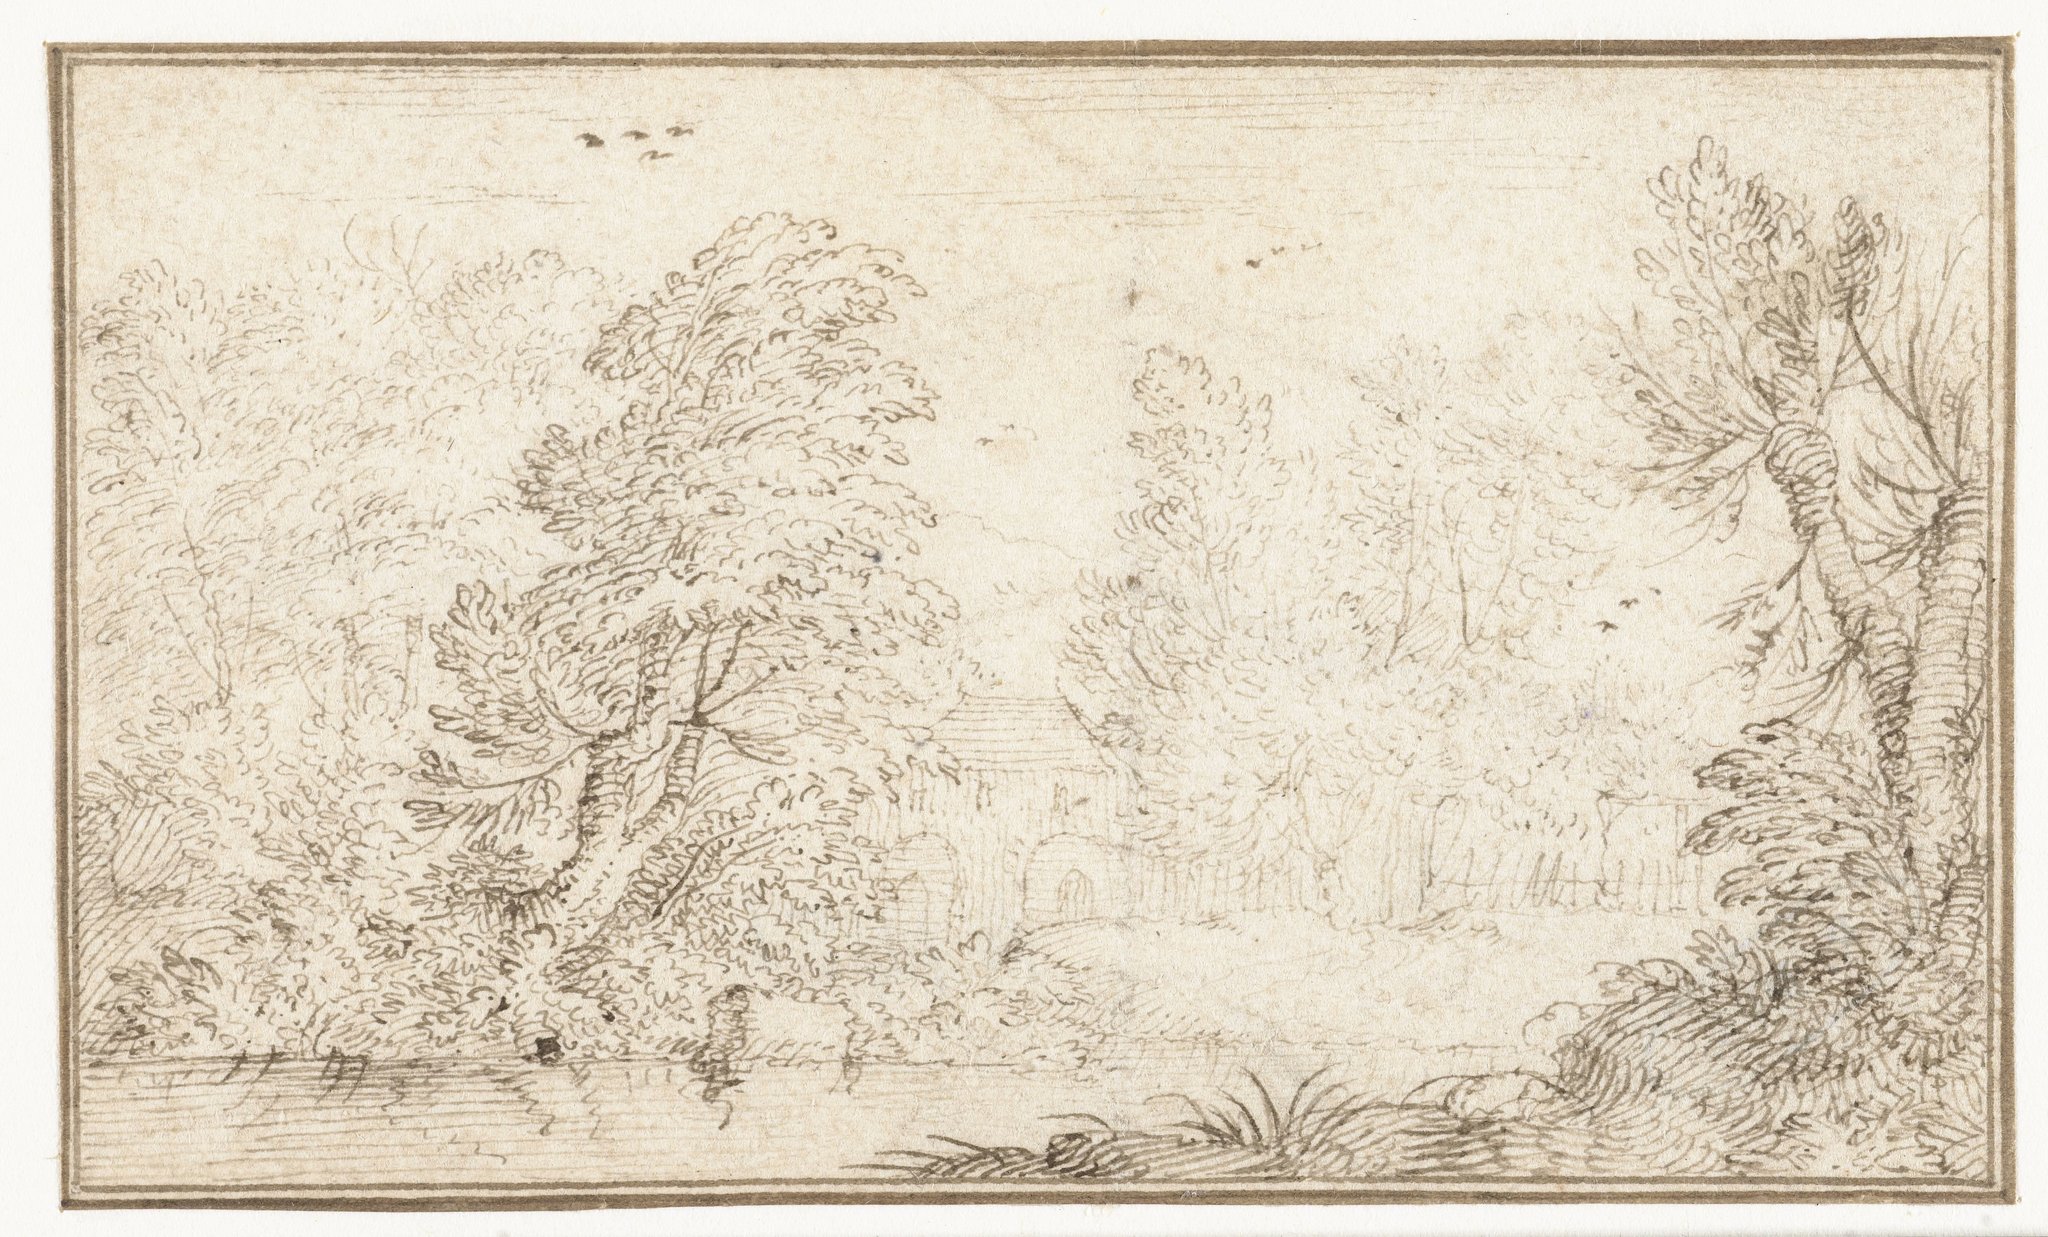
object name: drawing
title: Boslandschap met huis aan rivier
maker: albert flamen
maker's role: draughtsman, print maker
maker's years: 1620-1691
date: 1648-1669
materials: ink, paper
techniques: pen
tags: forest, wood